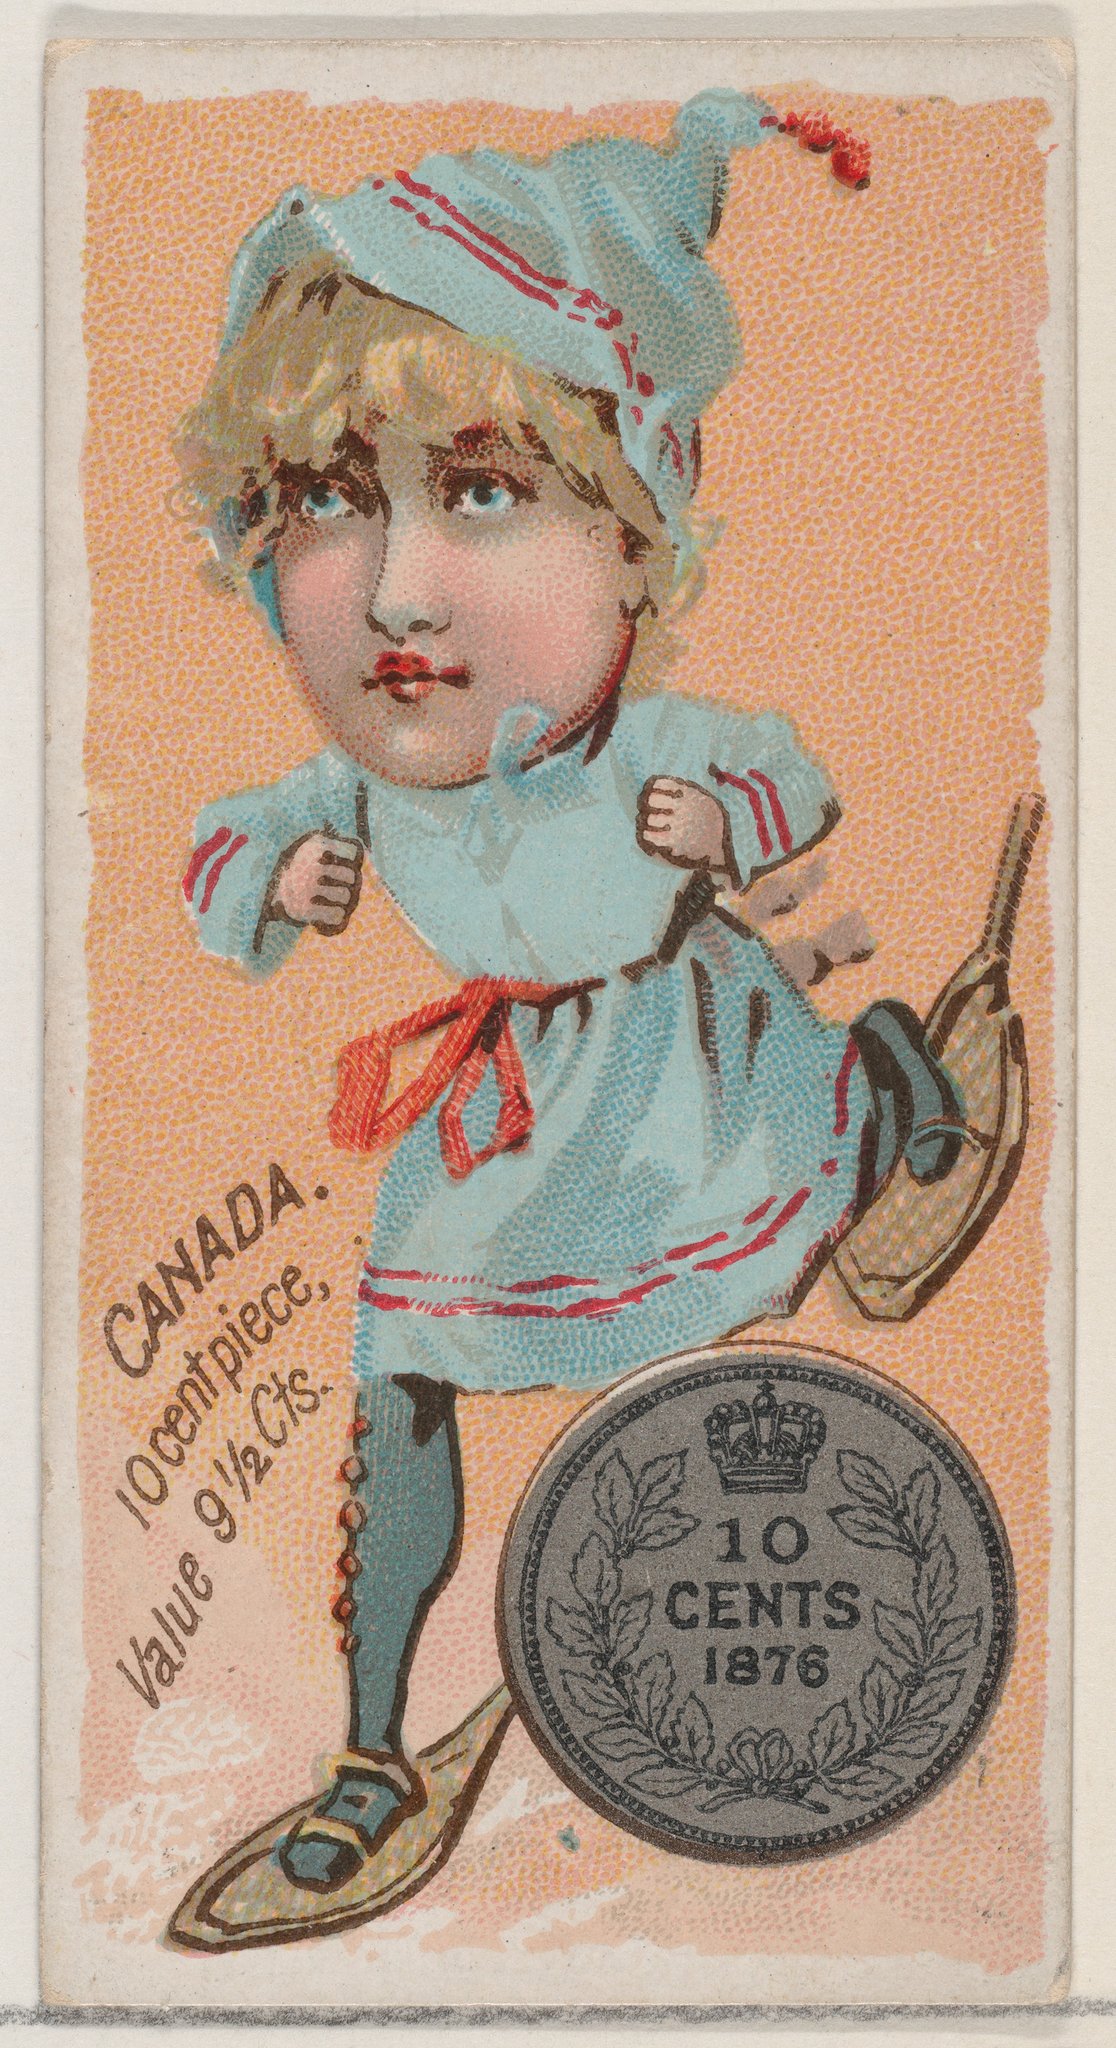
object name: print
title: Canada, 10 Cent Piece, from the series Coins of All Nations (N72, variation 2) for Duke brand cigarettes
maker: w. duke, sons & co.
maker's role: publisher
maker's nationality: american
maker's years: 1870-1920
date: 1889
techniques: color lithograph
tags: coins